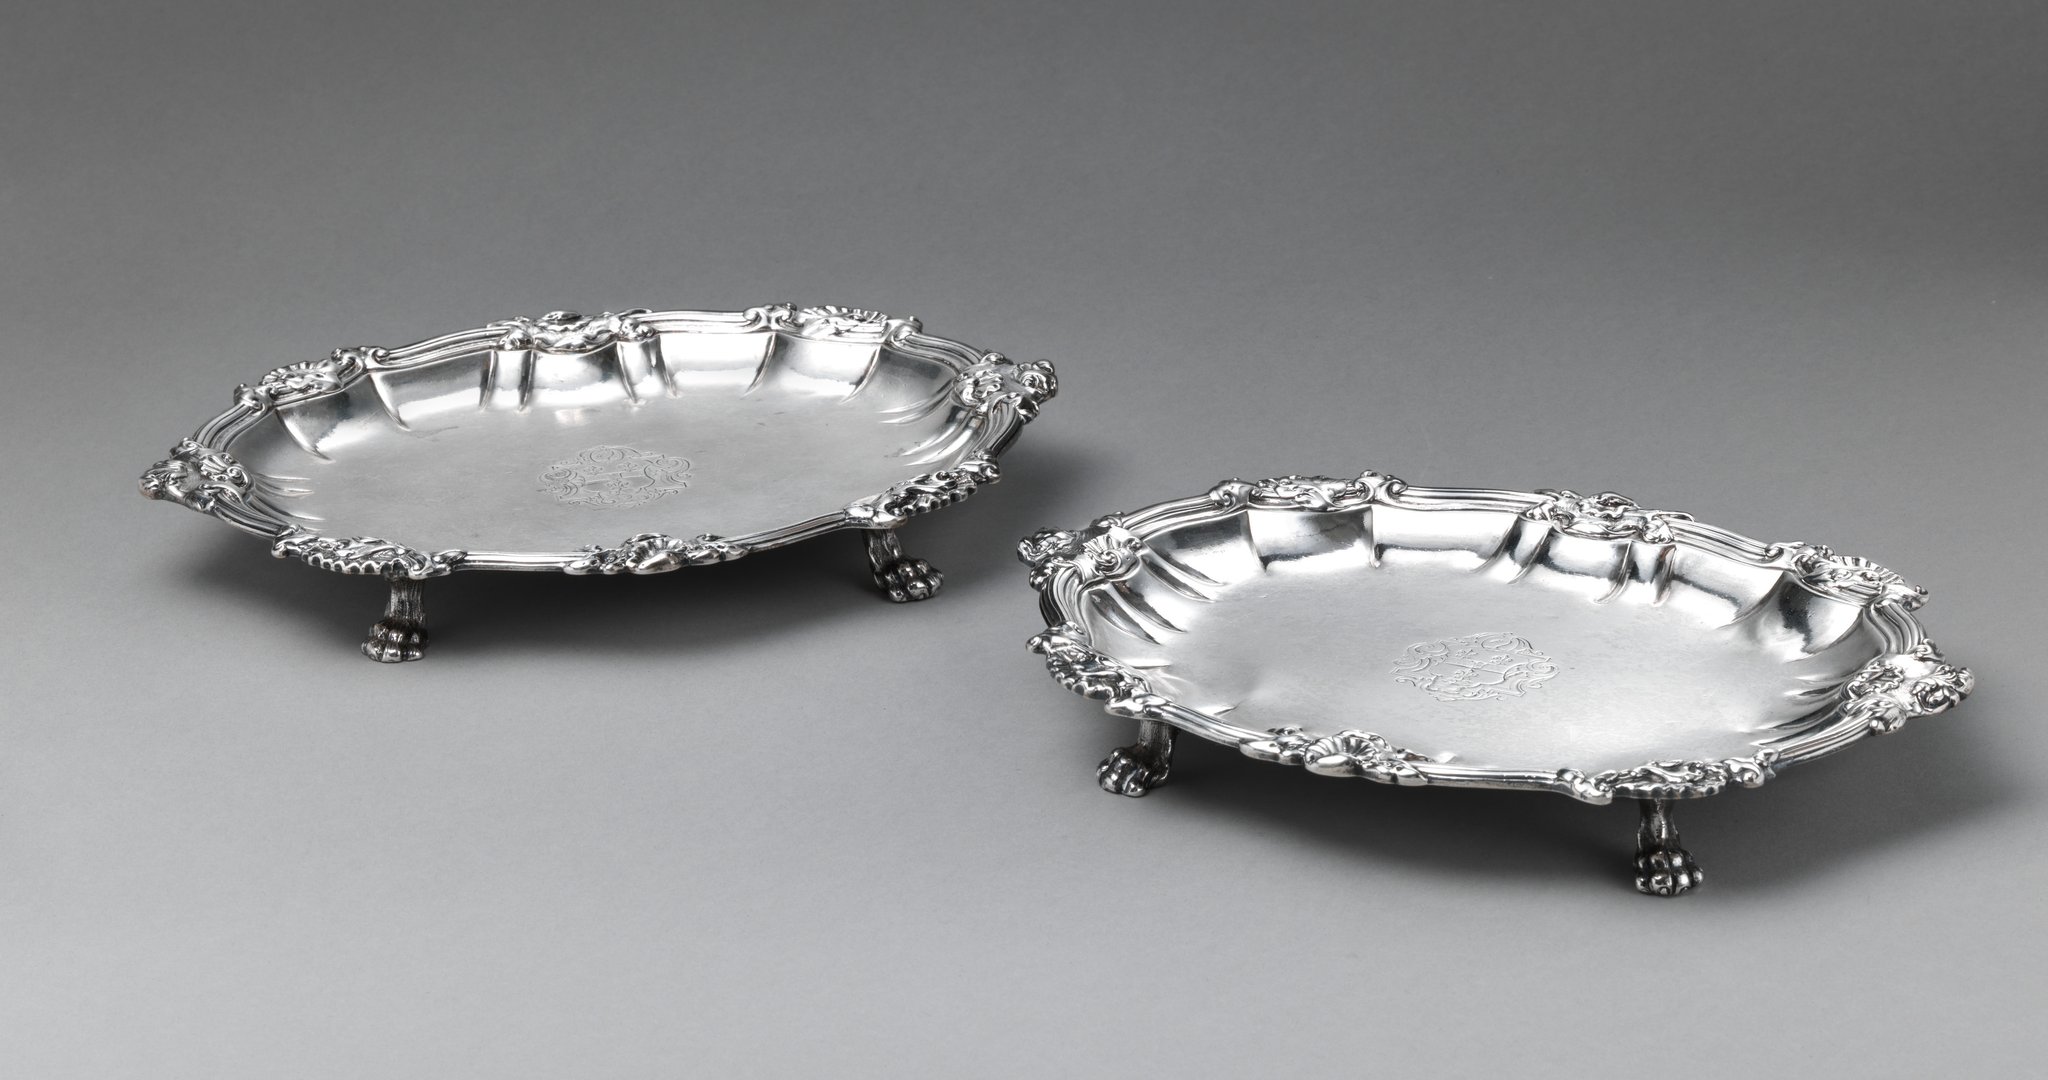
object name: tray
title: Pair of trays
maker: paul de lamerie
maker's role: maker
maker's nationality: british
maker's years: 1688-1751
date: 1739-1740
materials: silver